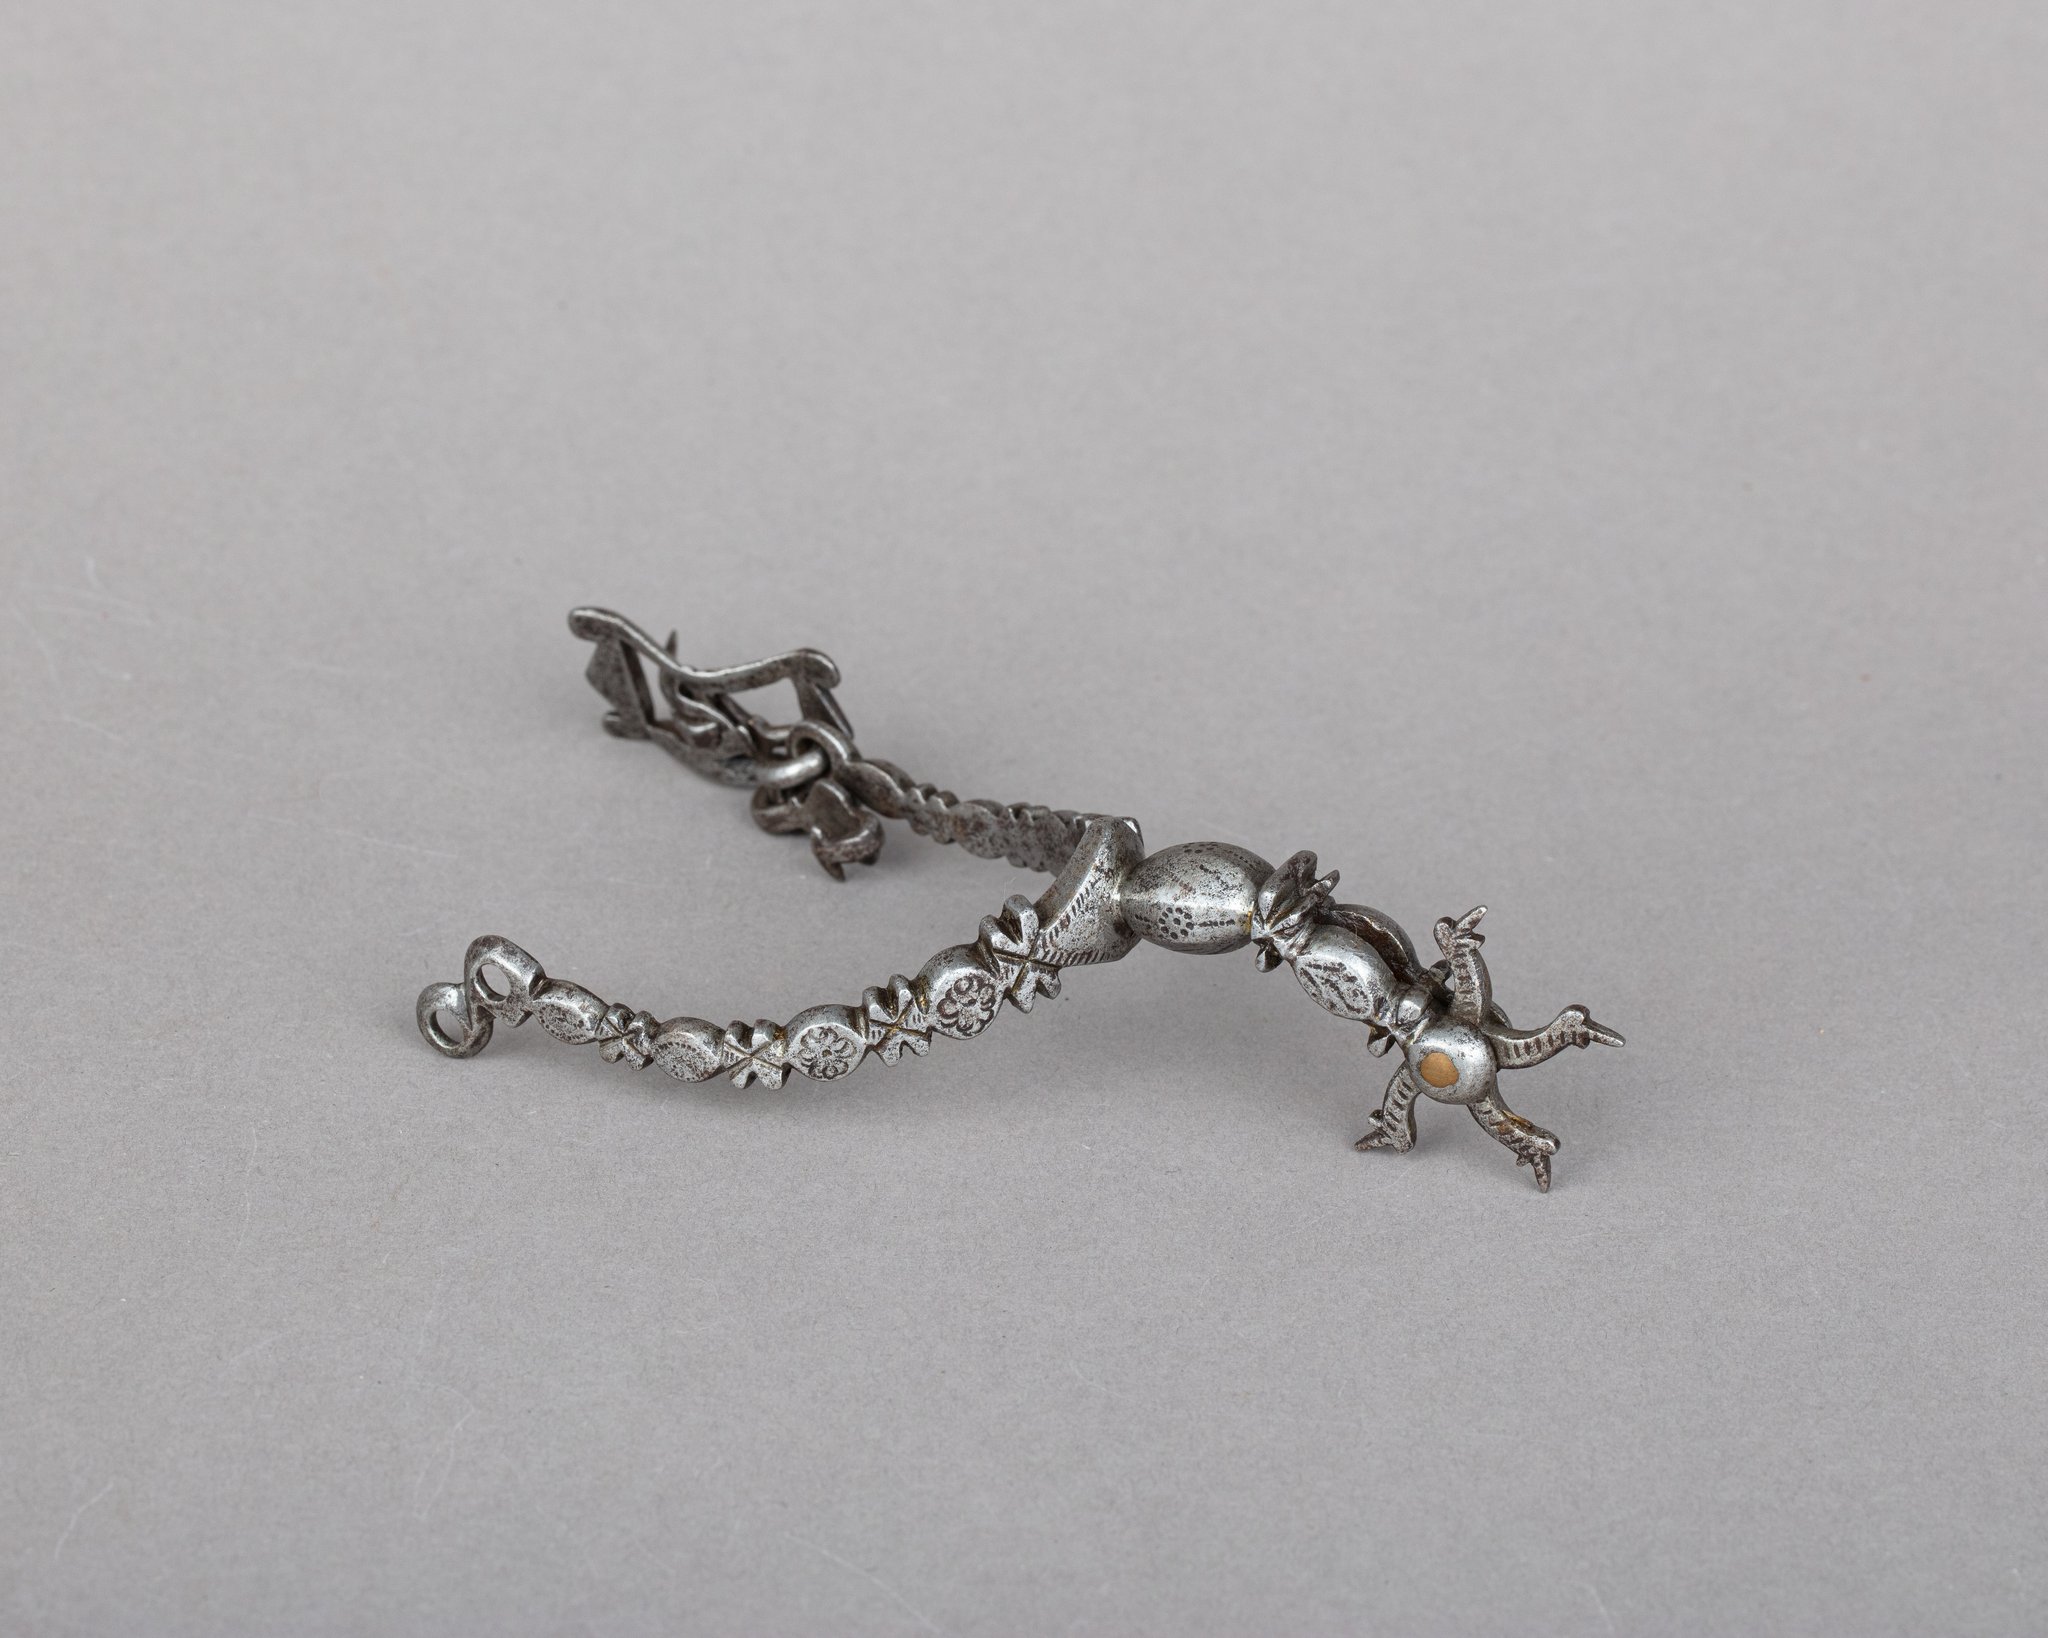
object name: spur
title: Rowel Spur (Right)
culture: german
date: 1601-1700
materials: metal alloy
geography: germany